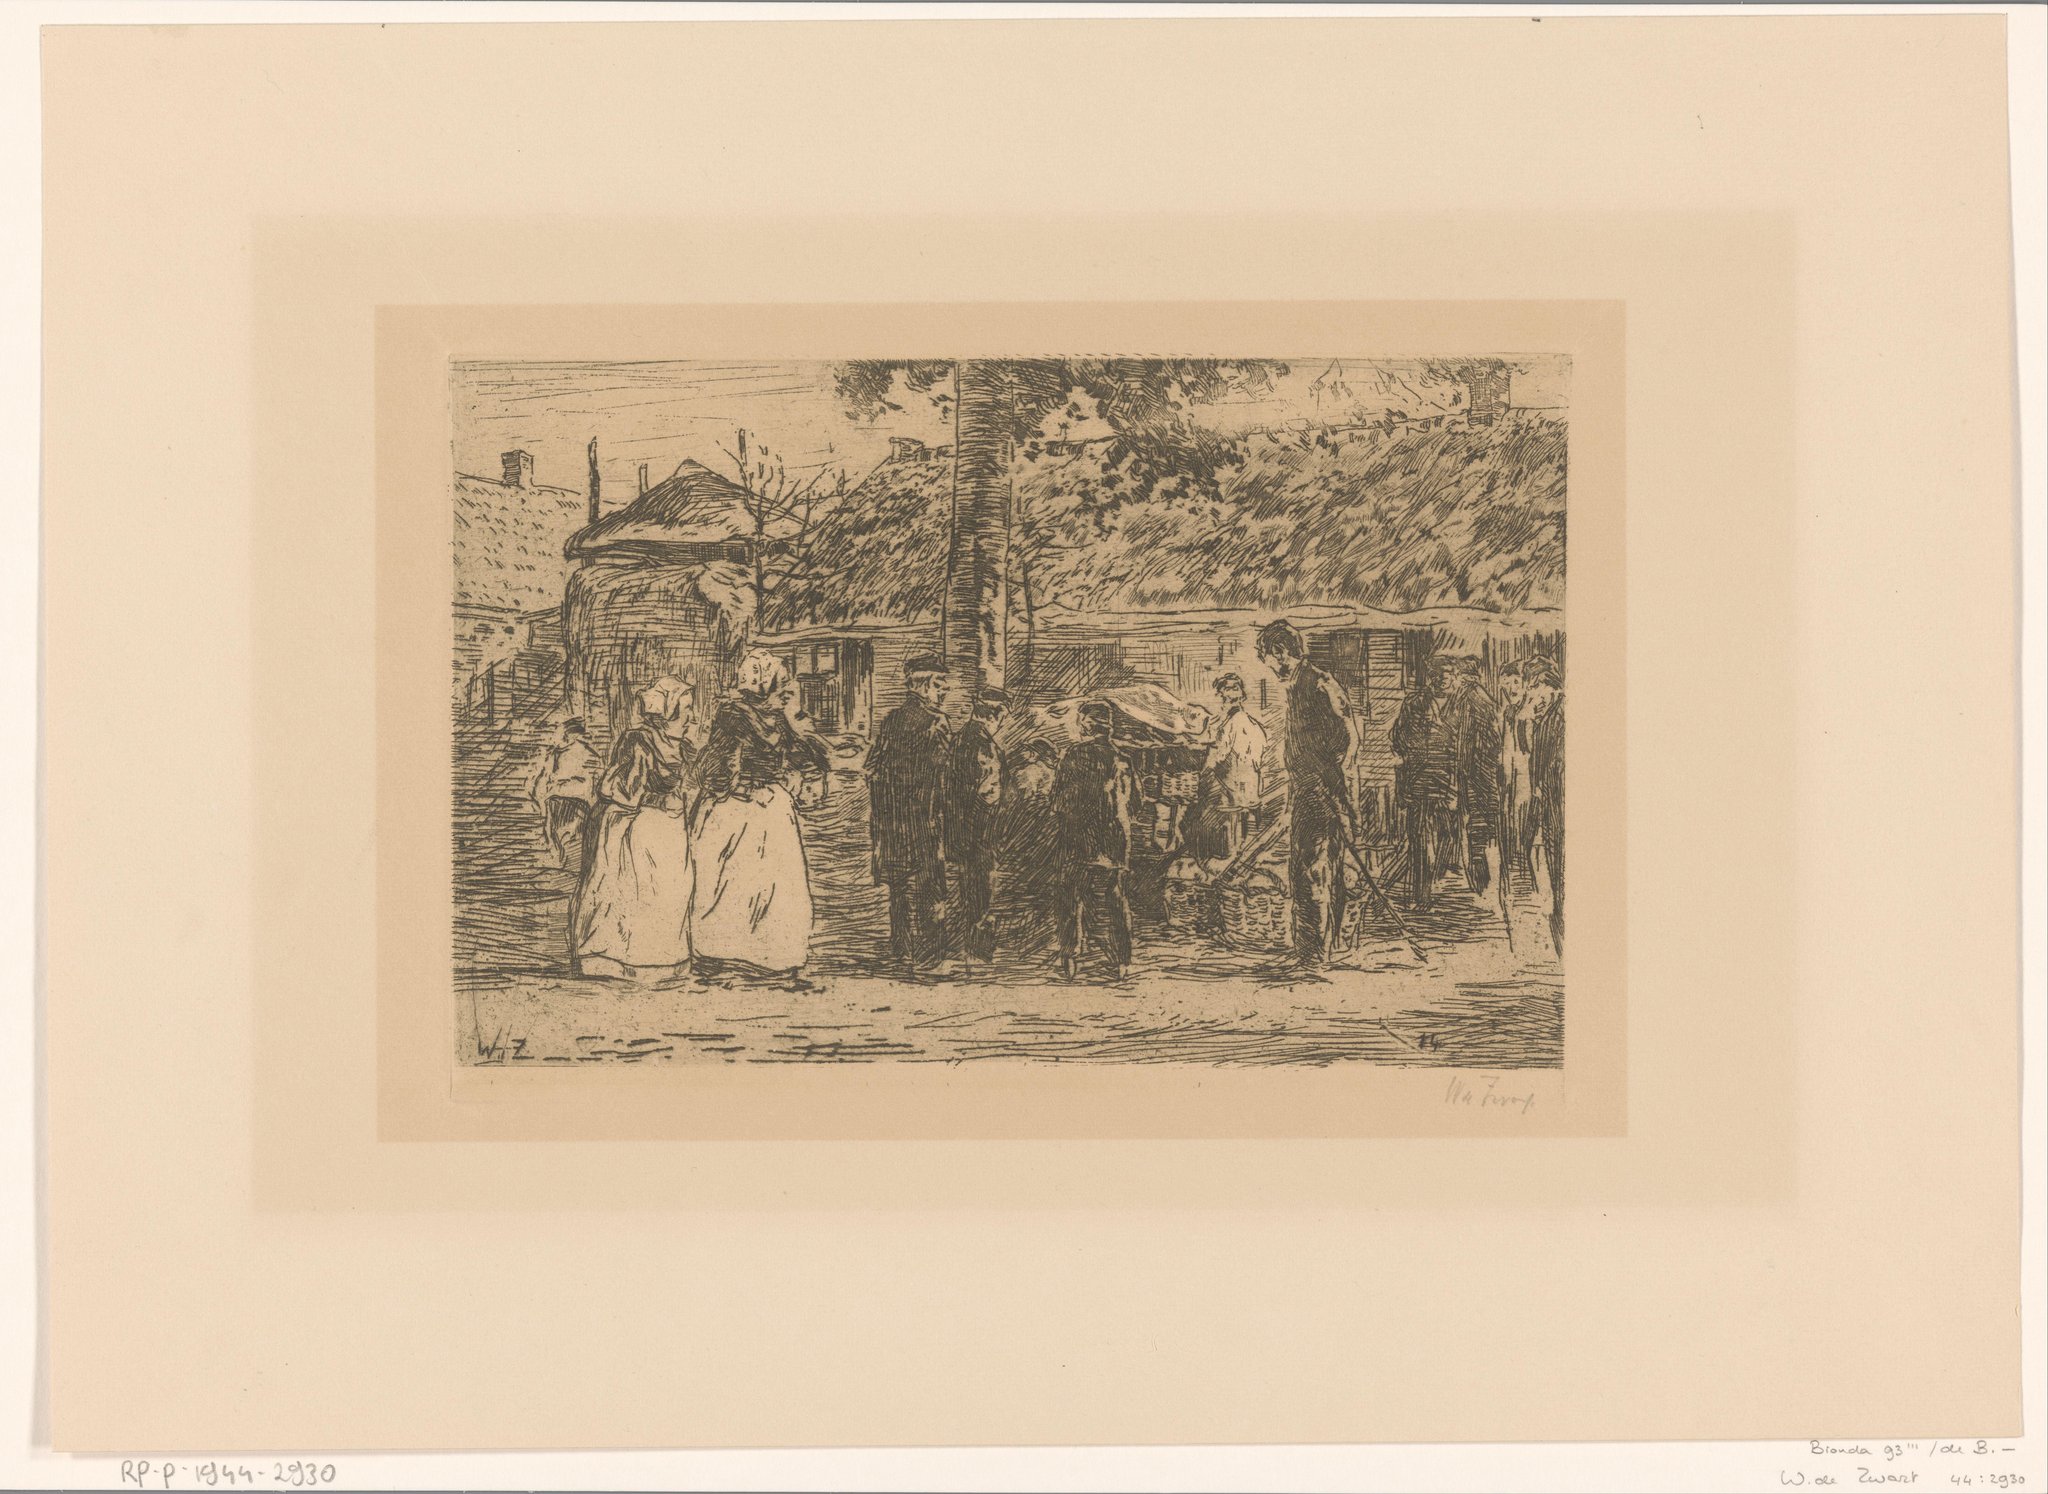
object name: print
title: Markt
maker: willem de zwart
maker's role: draughtsman, painter, print maker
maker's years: 1862-1931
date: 1924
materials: paper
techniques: drypoint, etching, intaglio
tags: village, market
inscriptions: collector's mark: Lugt 2228